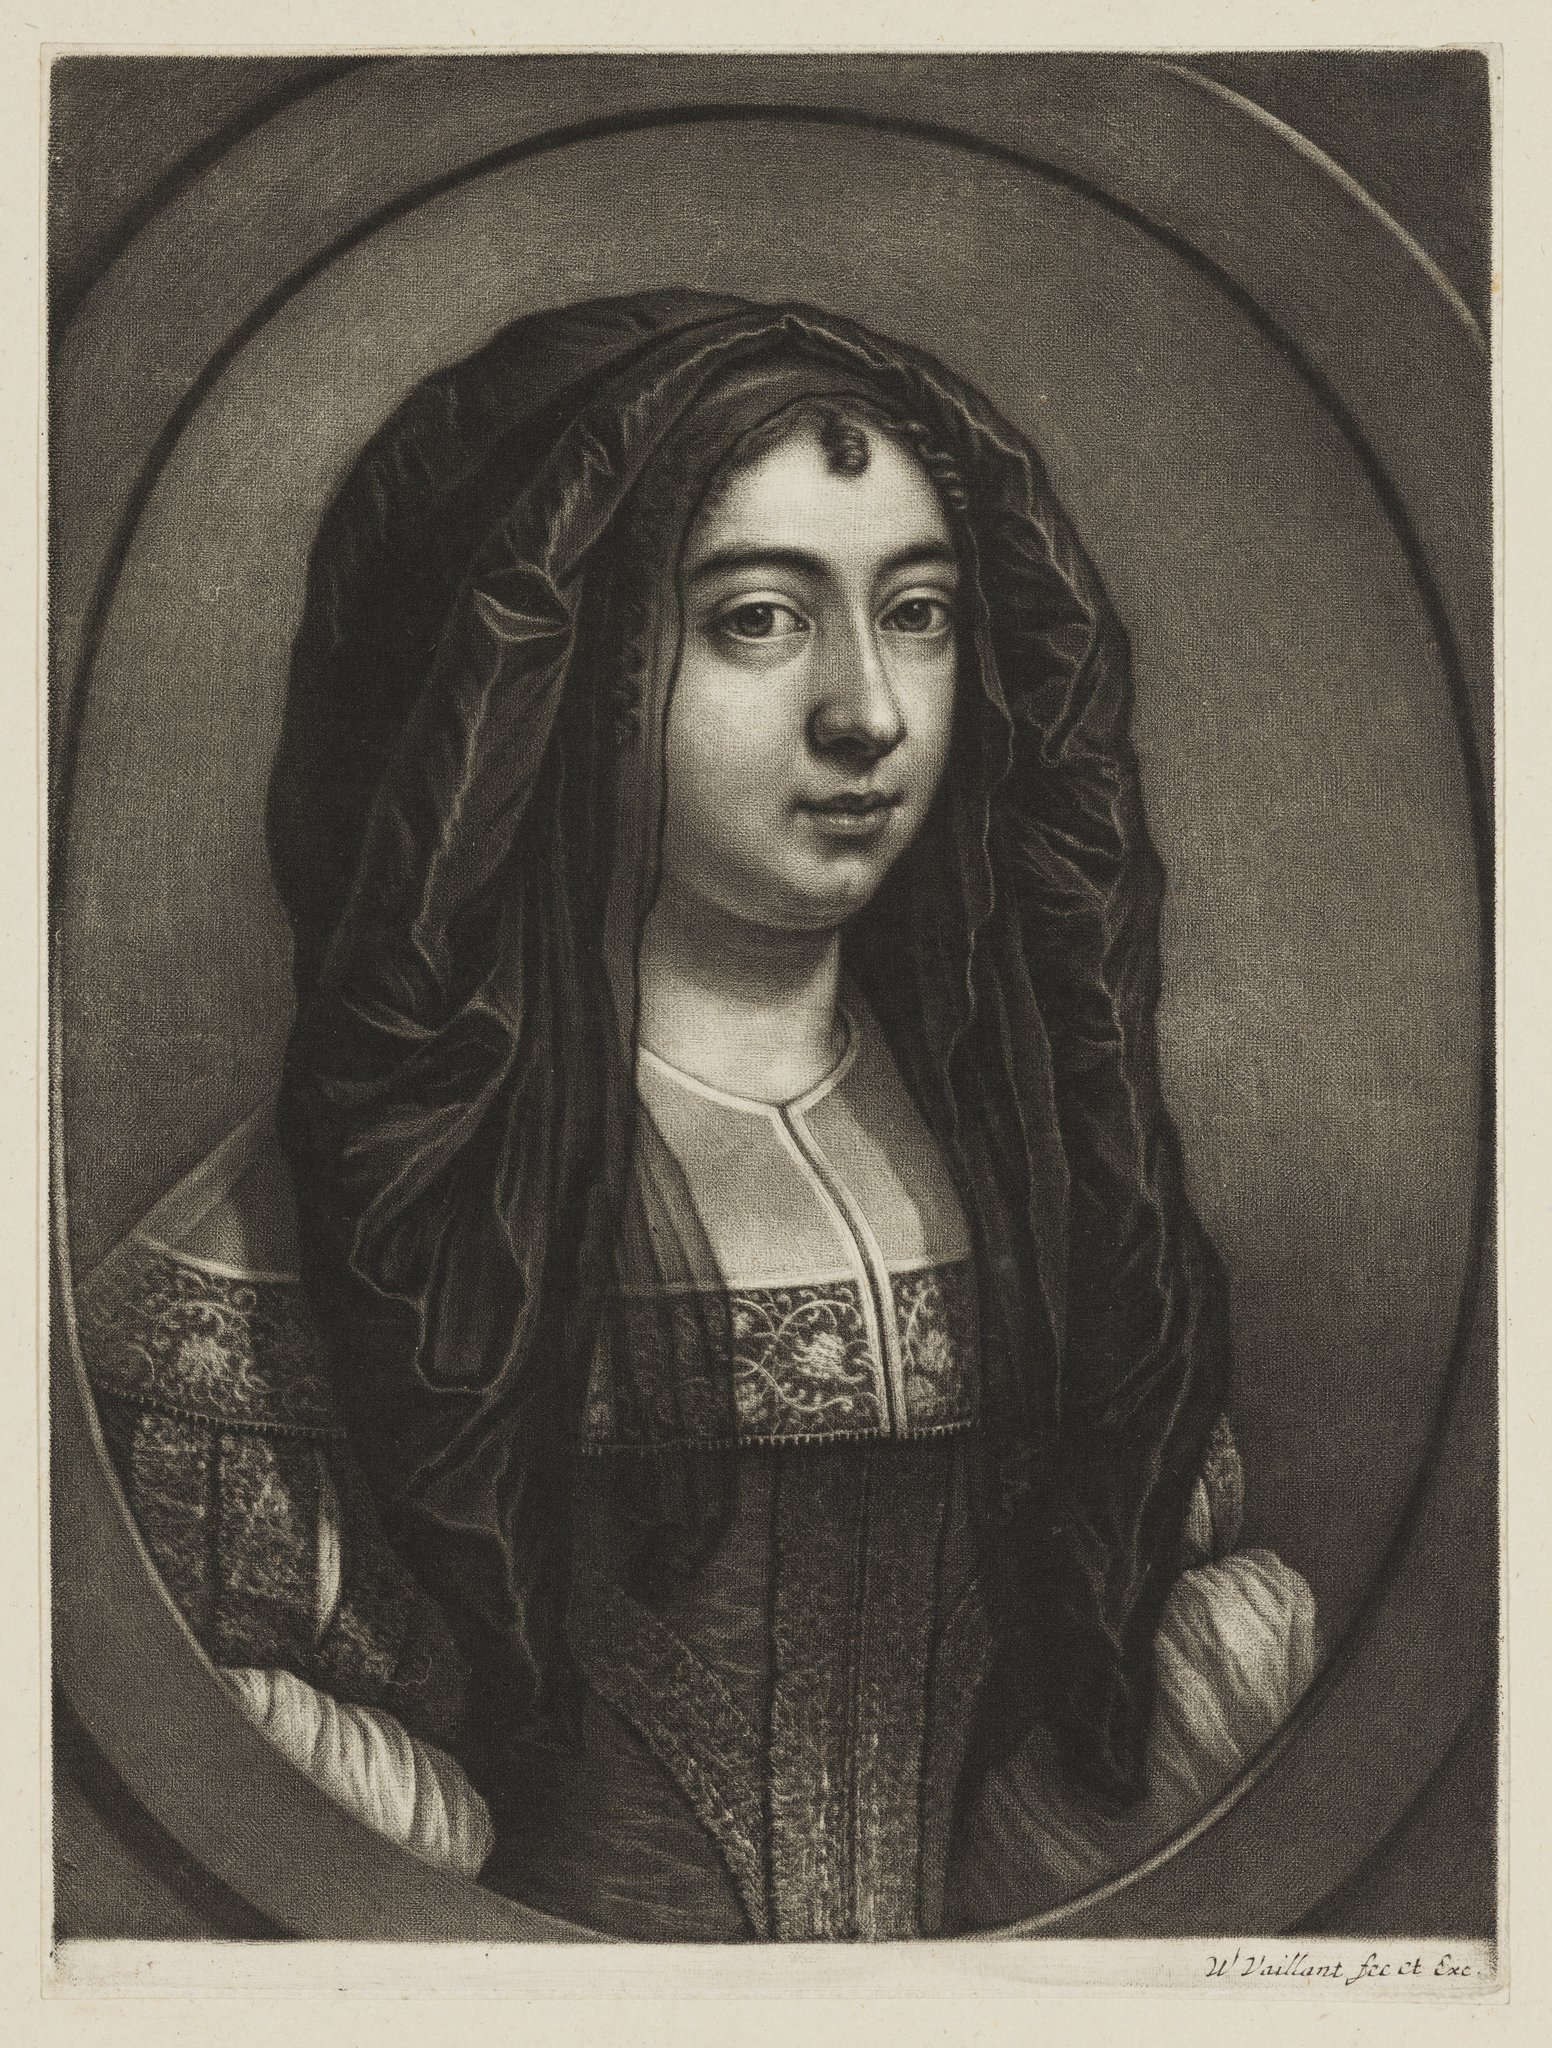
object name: print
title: Portrait of a Woman with a Veil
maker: wallerant vaillant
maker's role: artist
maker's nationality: dutch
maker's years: 1623-1677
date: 1601-1700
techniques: mezzotint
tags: portraits,women